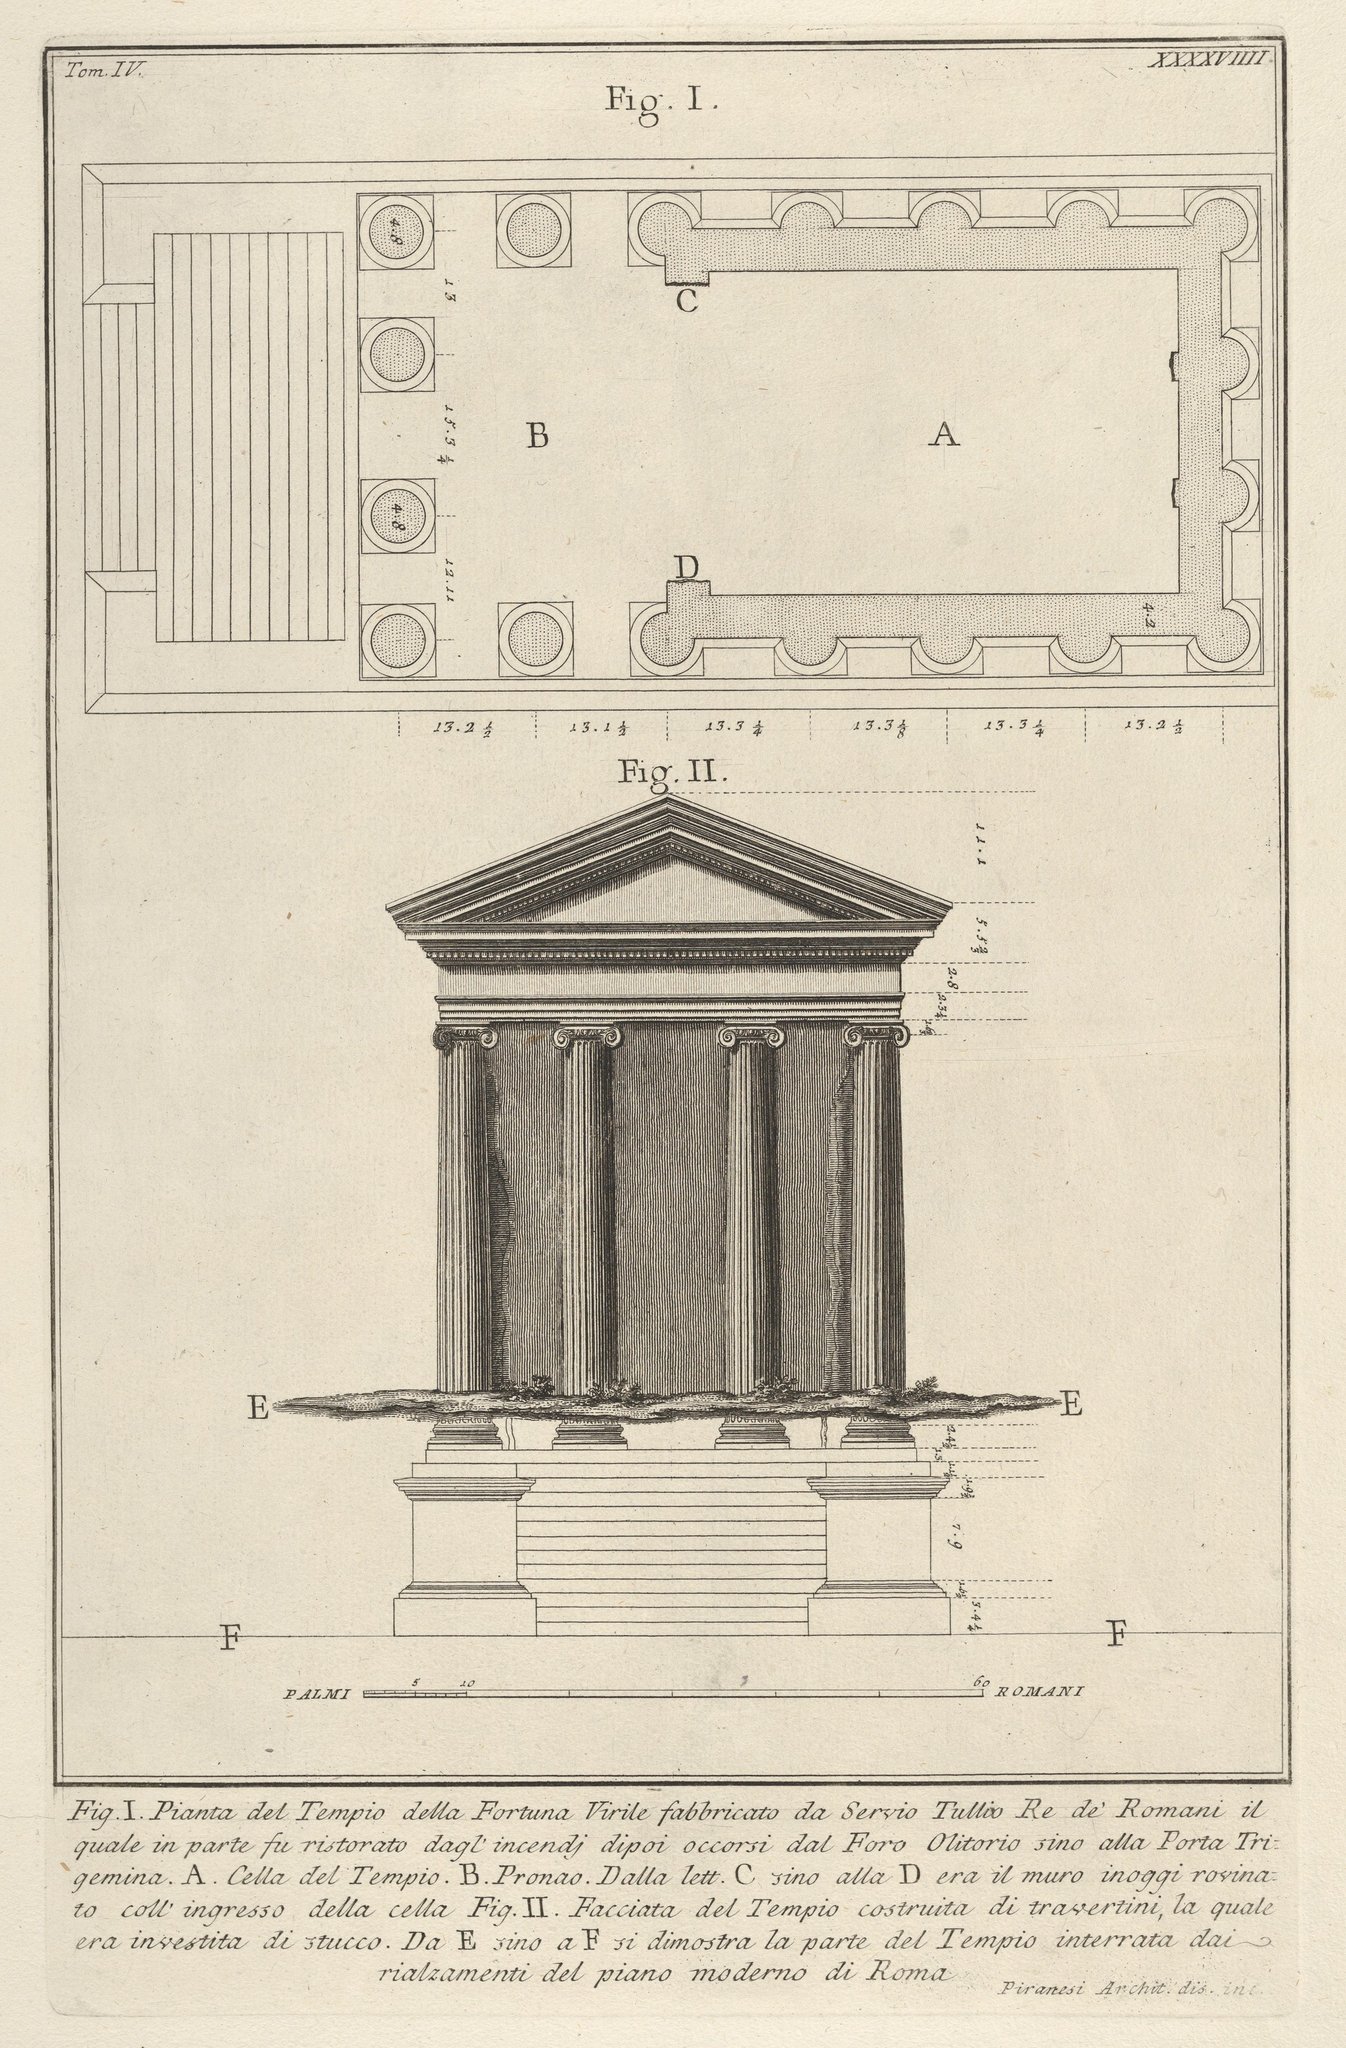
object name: print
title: Plan and facade of the Temple of Fortuna Virilis (Tempio della Fortuna Virile), from "Le Antichità Romane"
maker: giovanni battista piranesi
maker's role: artist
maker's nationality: italian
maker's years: 1720-1778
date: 1756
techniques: etching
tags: architecture,temples